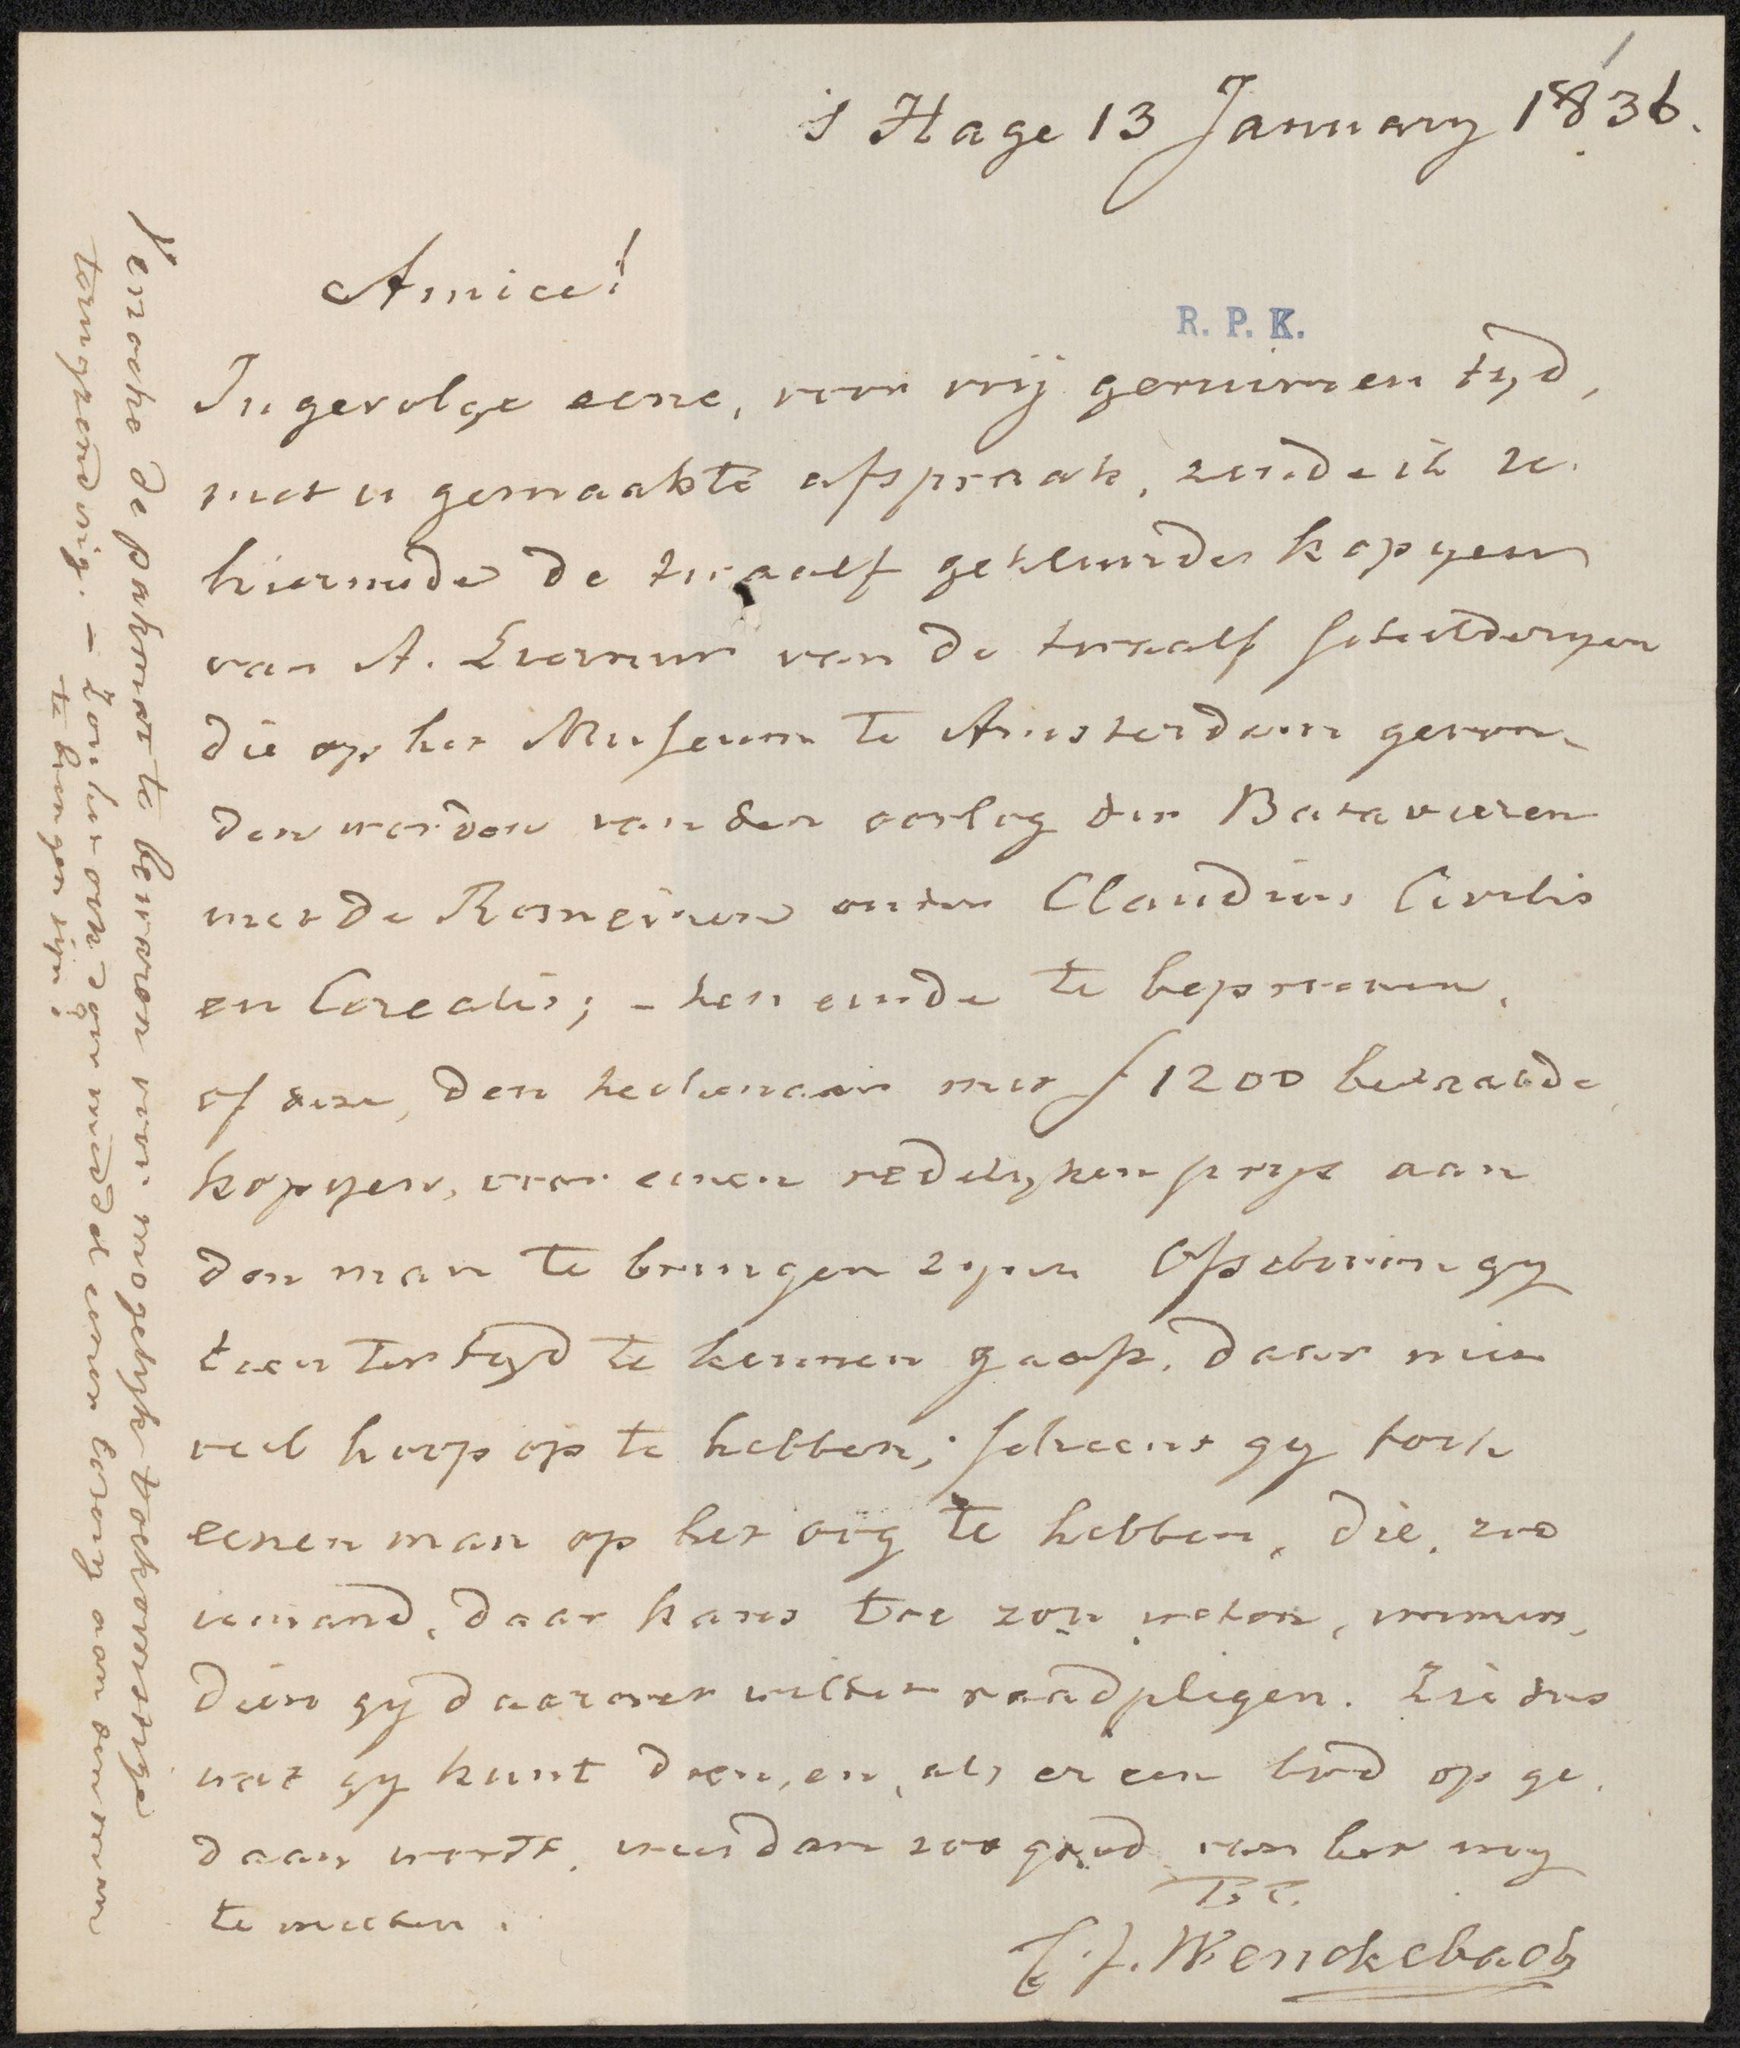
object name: letter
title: Brief aan anoniem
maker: Anonymous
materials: ink, paper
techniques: pen, writing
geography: the hague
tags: the hague, draughtsman, alexander liernur, art trade, art shop, money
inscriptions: watermark, collector's mark: Lugt 2233, collector's mark: Lugt 2228a